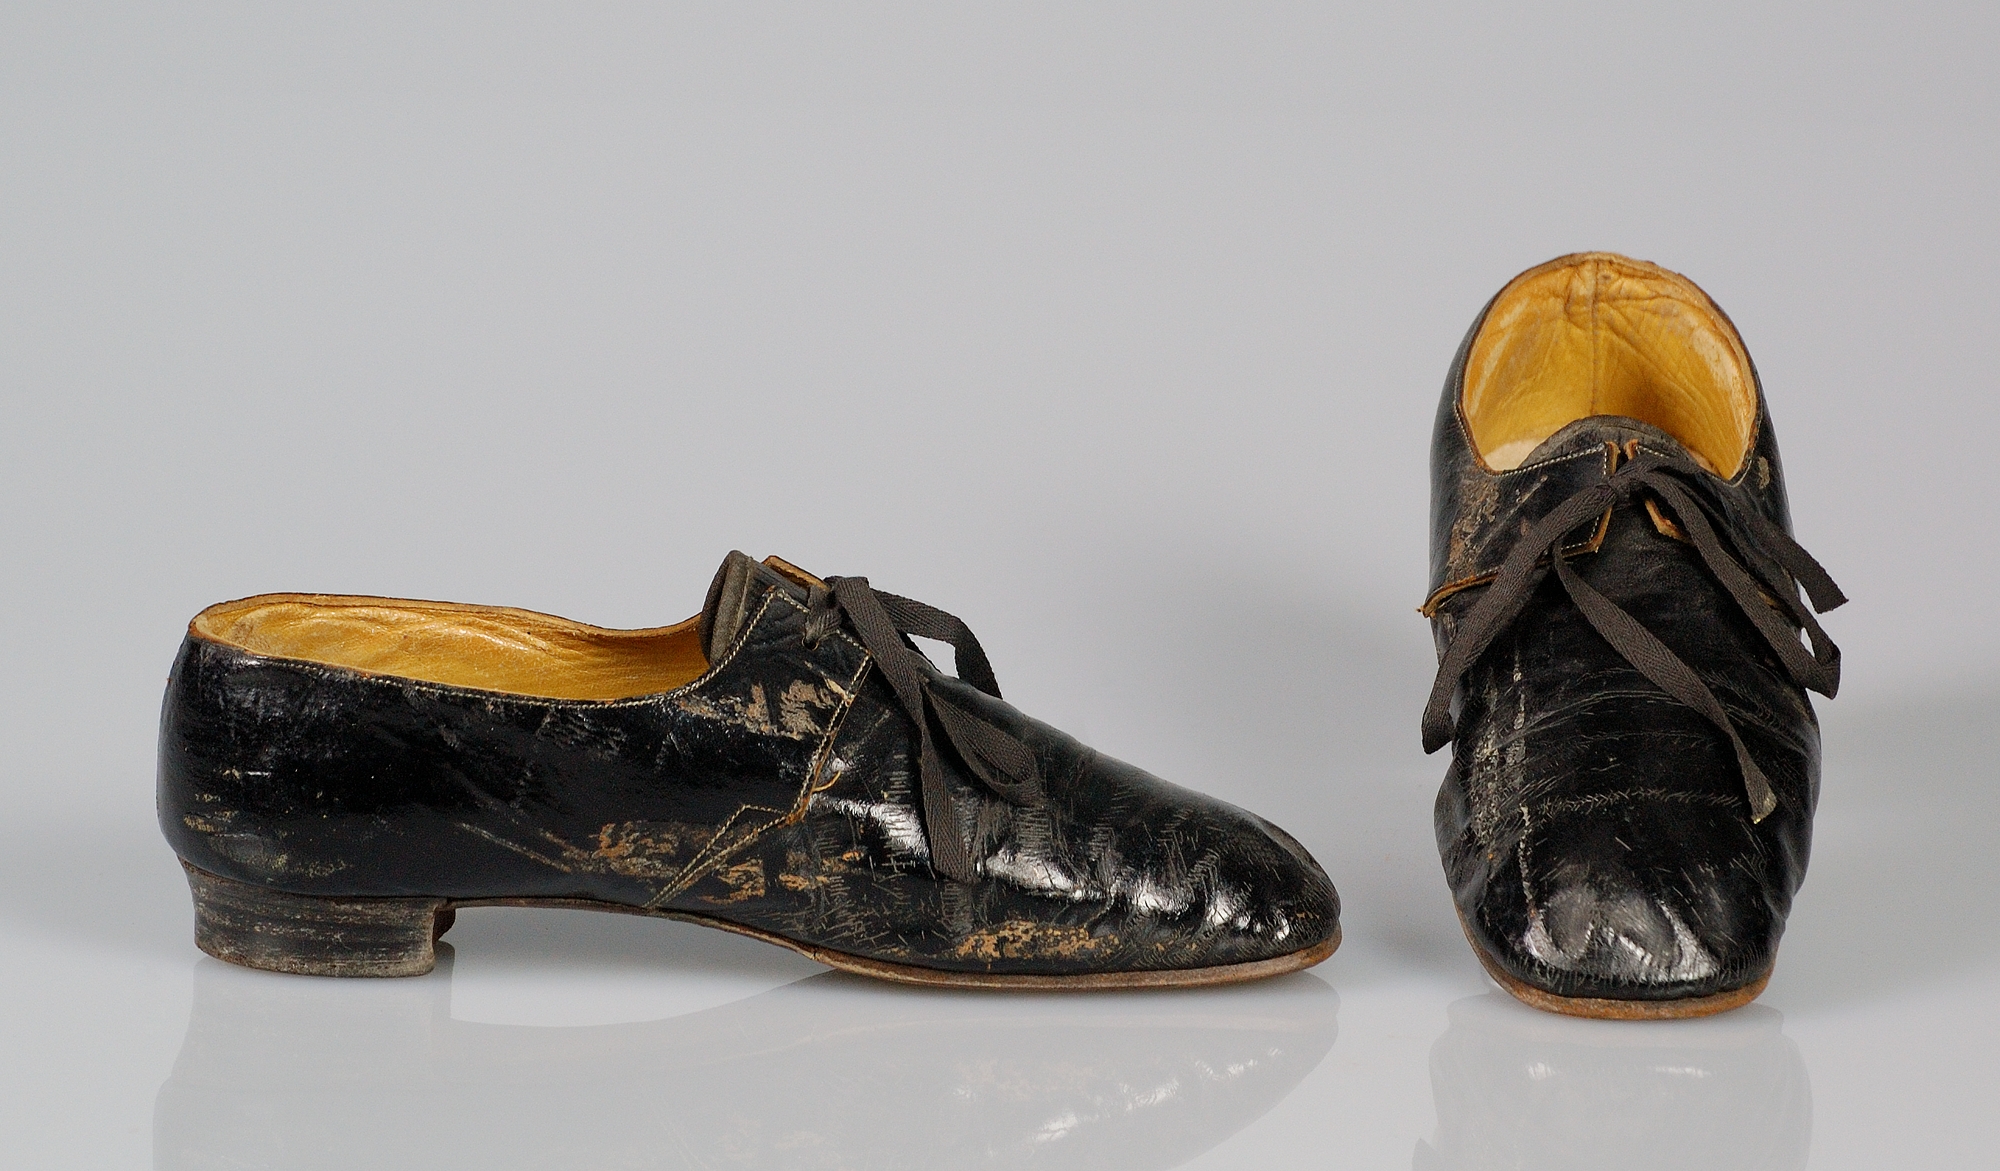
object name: shoe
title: Shoes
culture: american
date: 1845-1865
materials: leather